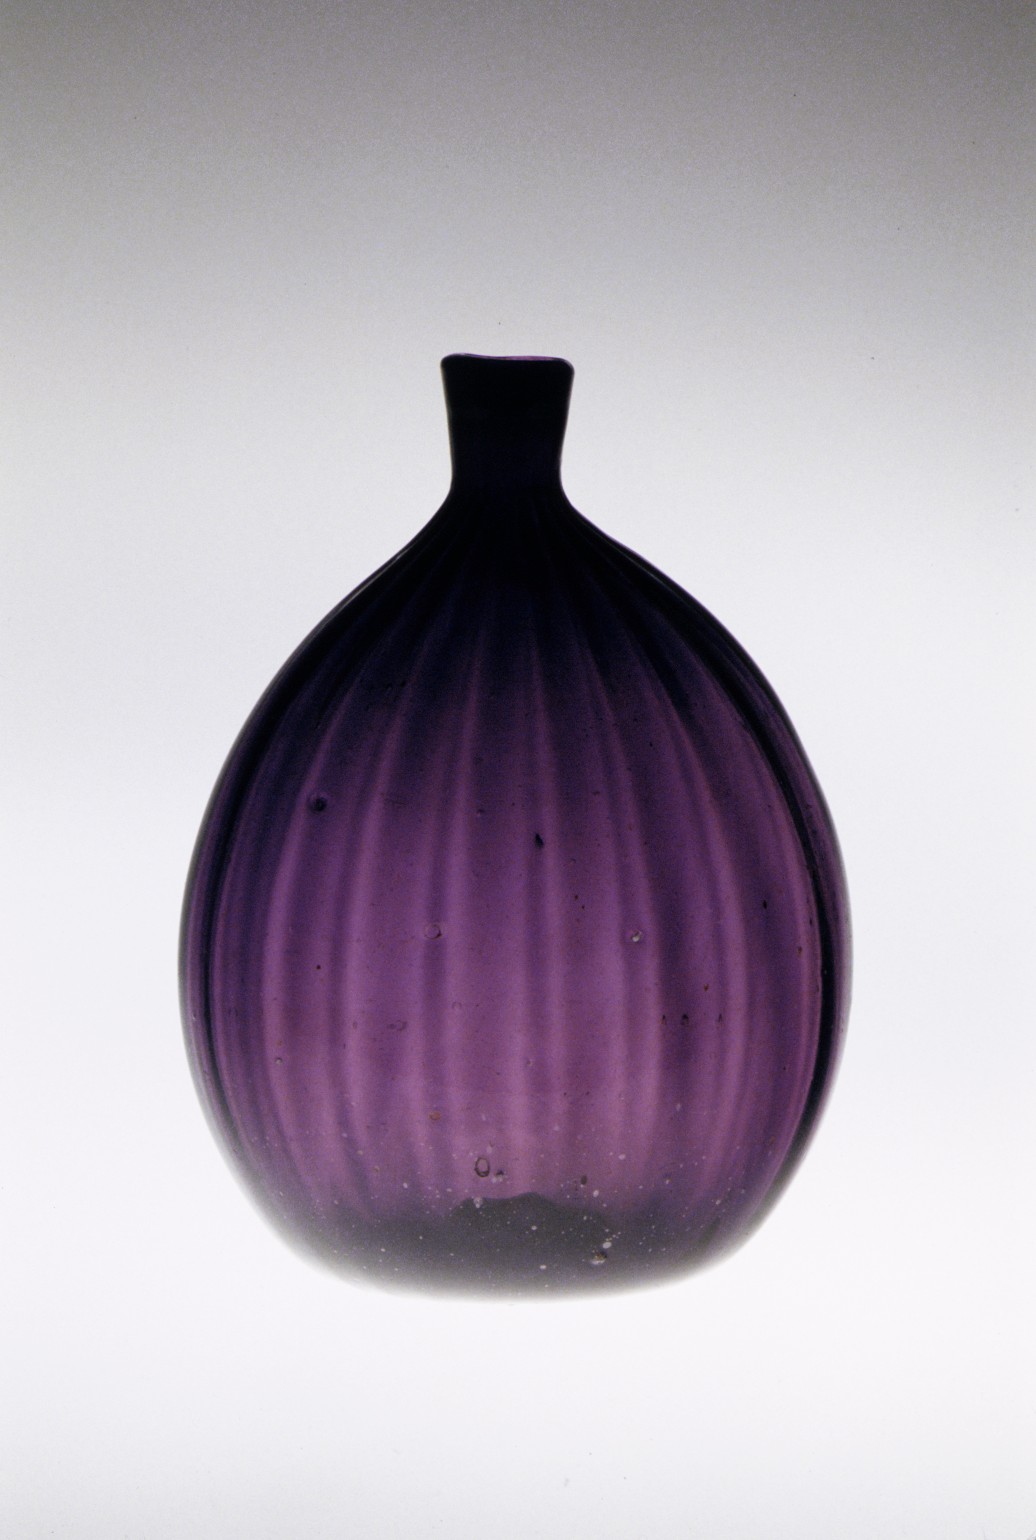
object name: pocket flask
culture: american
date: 1800-1860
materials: glass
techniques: glassblowing, molding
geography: united states